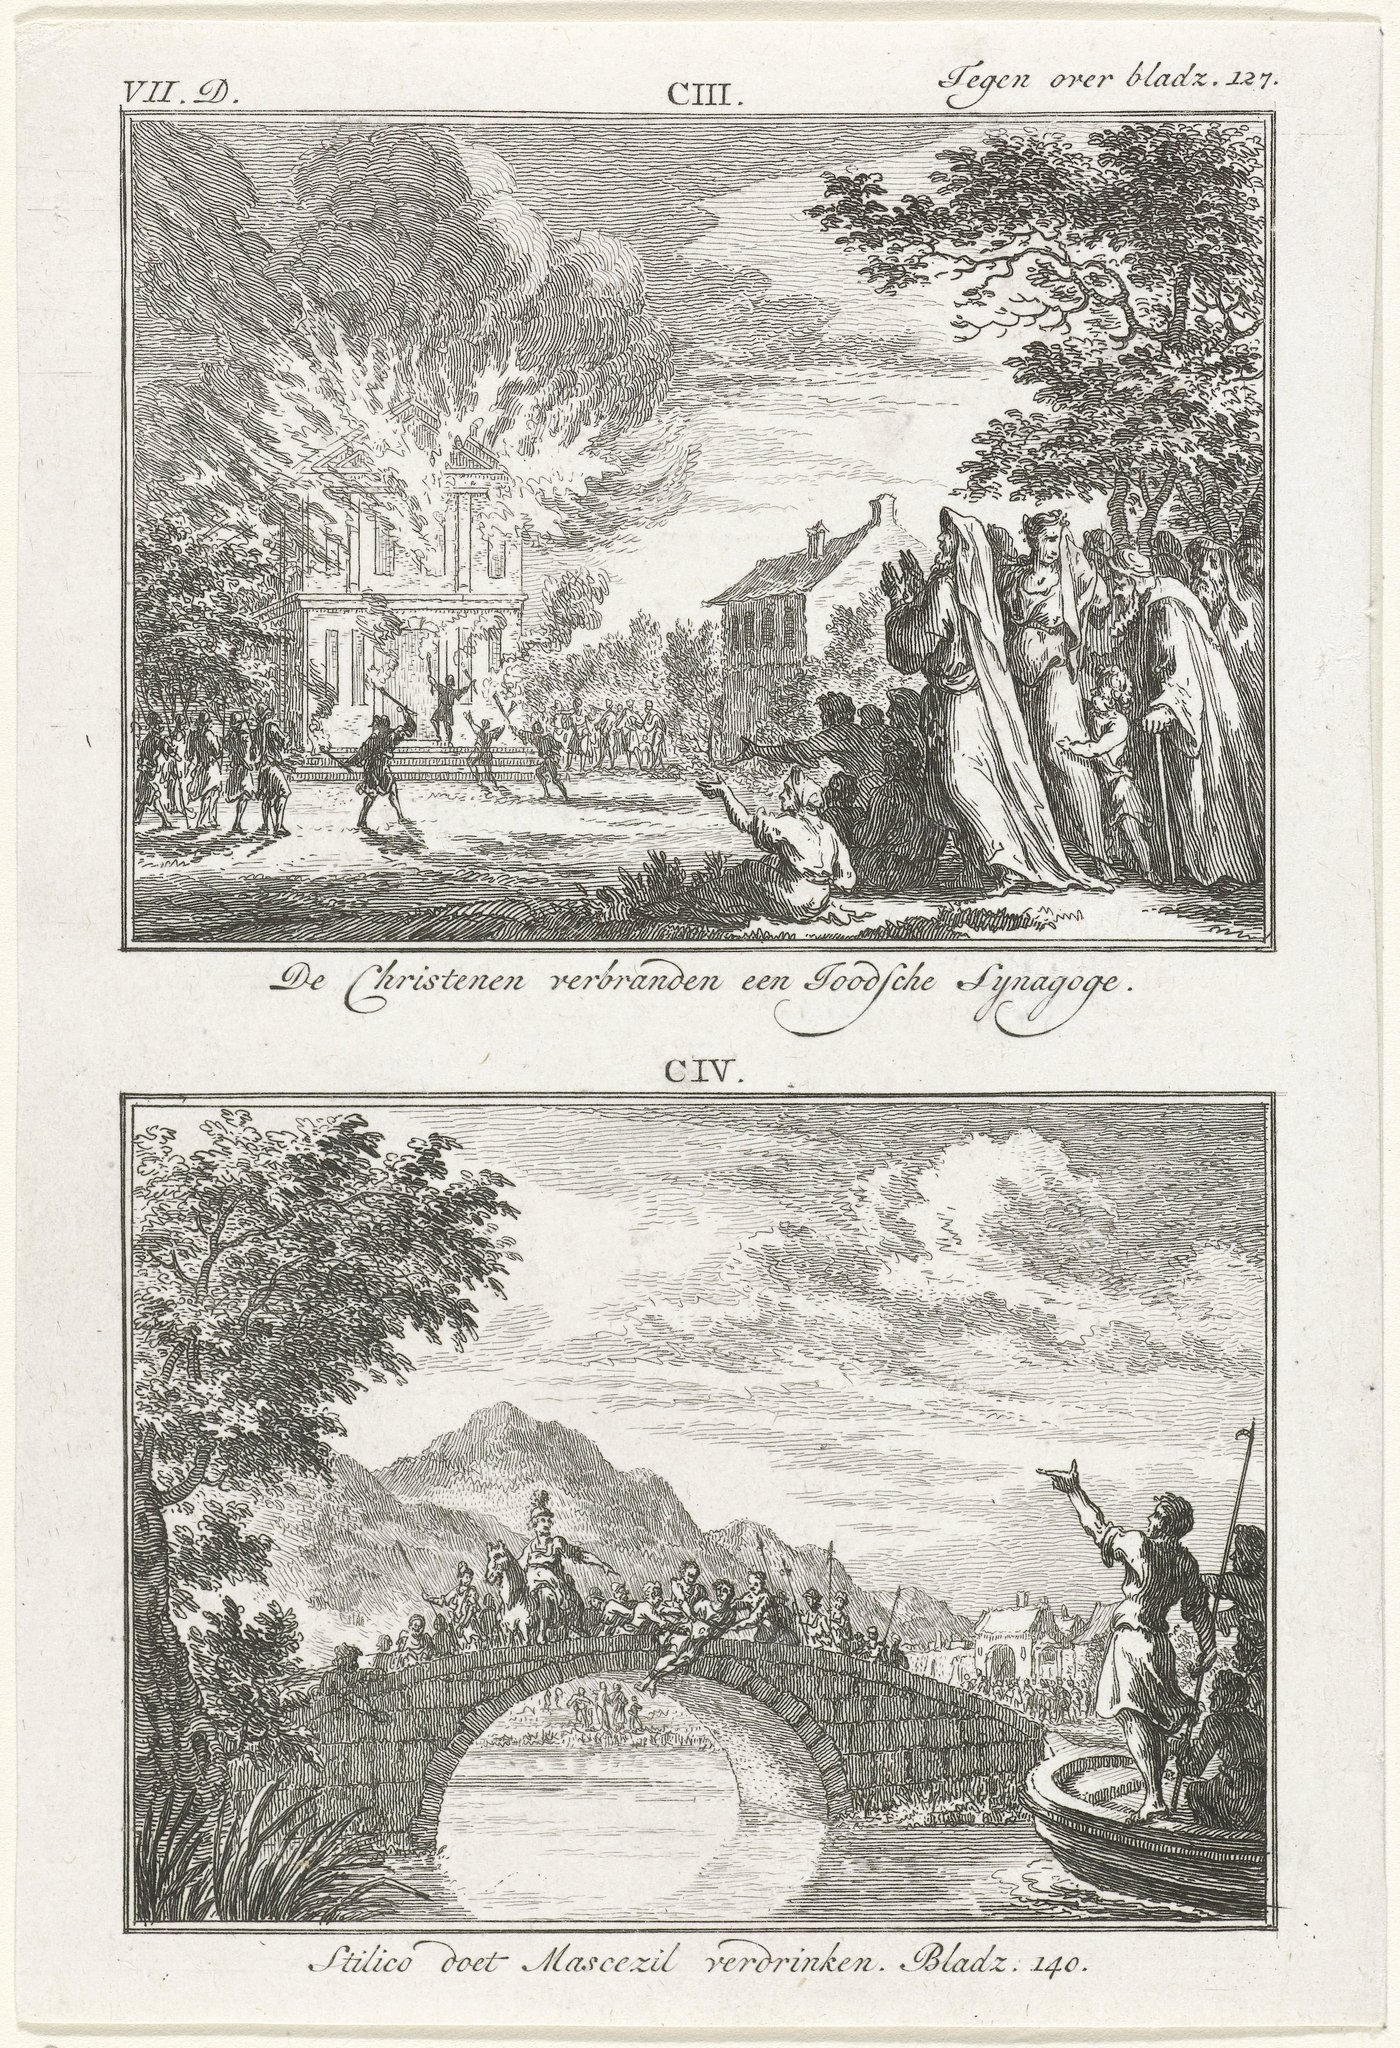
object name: book illustration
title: Illustratie voor de Romeinse geschiedenis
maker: simon fokke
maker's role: draughtsman, print maker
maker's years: 1712-1784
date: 1722-1784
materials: paper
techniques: etching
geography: amsterdam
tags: on fire, ablaze, the synagogue (as building and place of worship ~ jewish religion), violent death, being killed; being mishandled and maltreated; seeking death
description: Voorstellingen uit de Romeinse geschiedenis. Boven: Met brandende toortsen steken figuren een synagoge in brand. Op de voorgrond een groep joodse mensen in rouw. Onder: Gewapende figuren op een brug houden Mascezil boven het water. Flavius Stilichote lijkt vanaf zijn paard bevelen te geven. Twee voorstellingen van één plaat, respectievelijk genummerd: CIII en CIV. Het blad is linksboven gemerkt: VII.D.